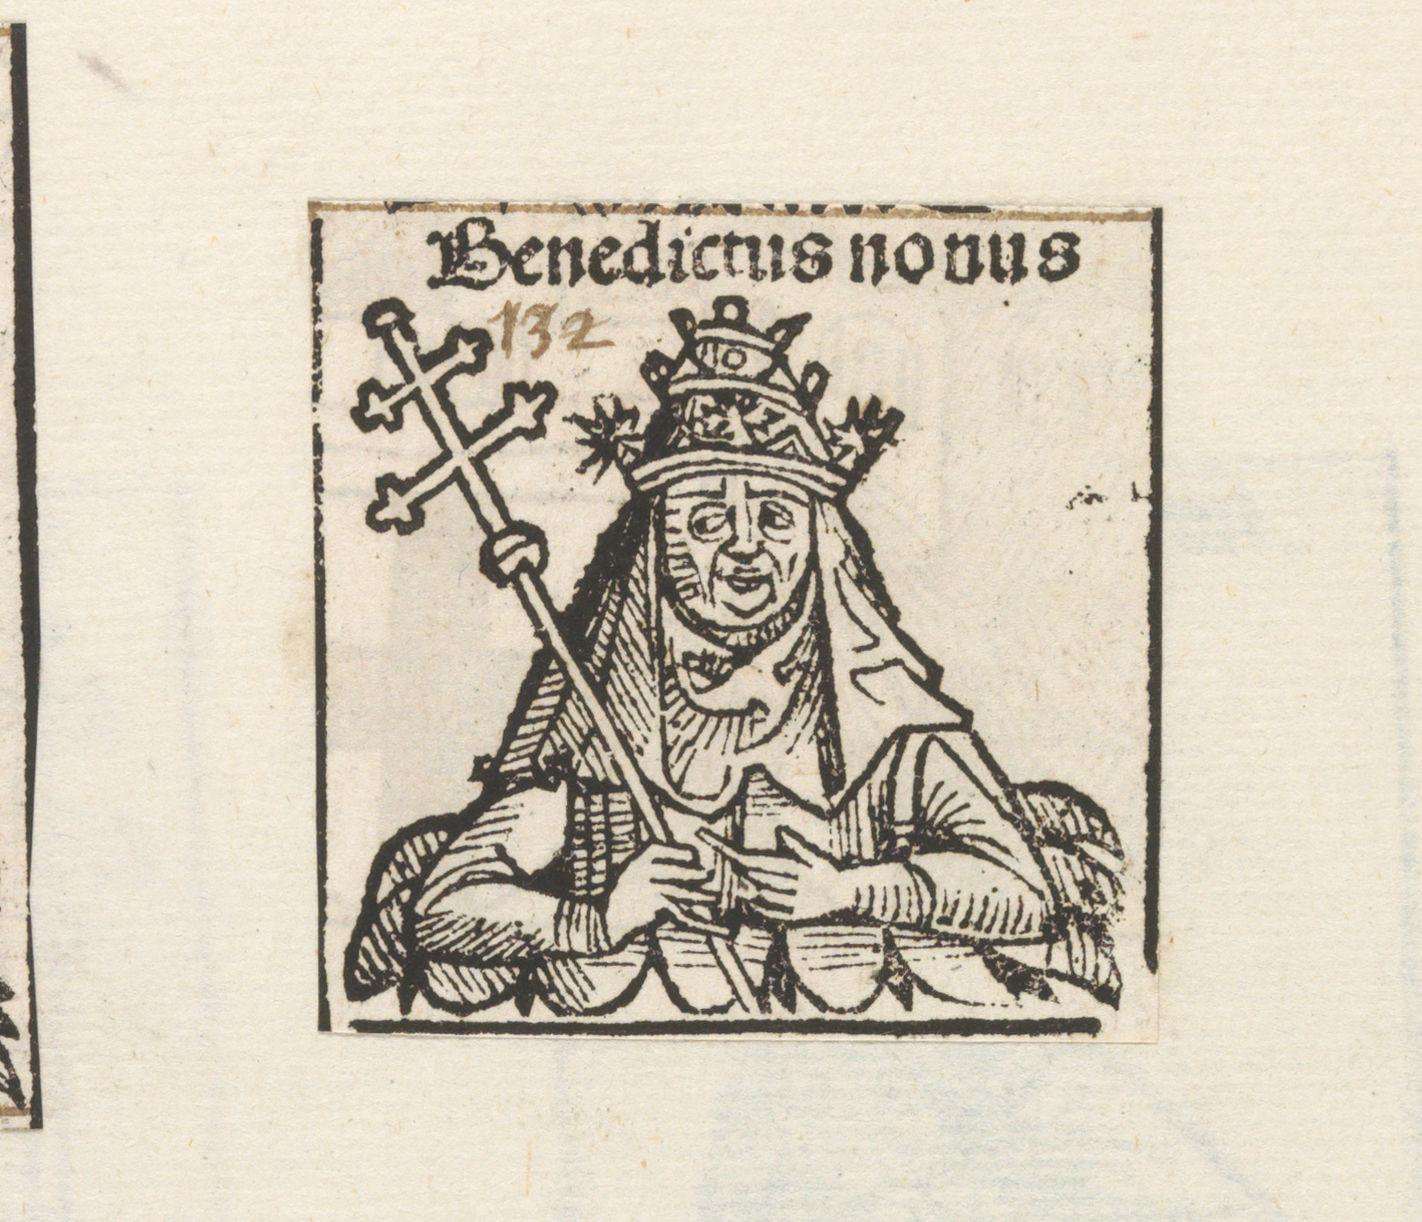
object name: print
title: Benedictus nonus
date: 1493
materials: paper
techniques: letterpress printing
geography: nuremberg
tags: pope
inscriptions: inscription: ‘132’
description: Een bloemkelk met een paus. Hij draagt een tiara en heeft een staf met dubbel kruis in zijn handen. De voorstelling is onderdeel van de opeenvolging pausen in de Liber Chronicarum. De tekst identificeert de man als Benedictus IX. De prent maakt deel uit van een album.